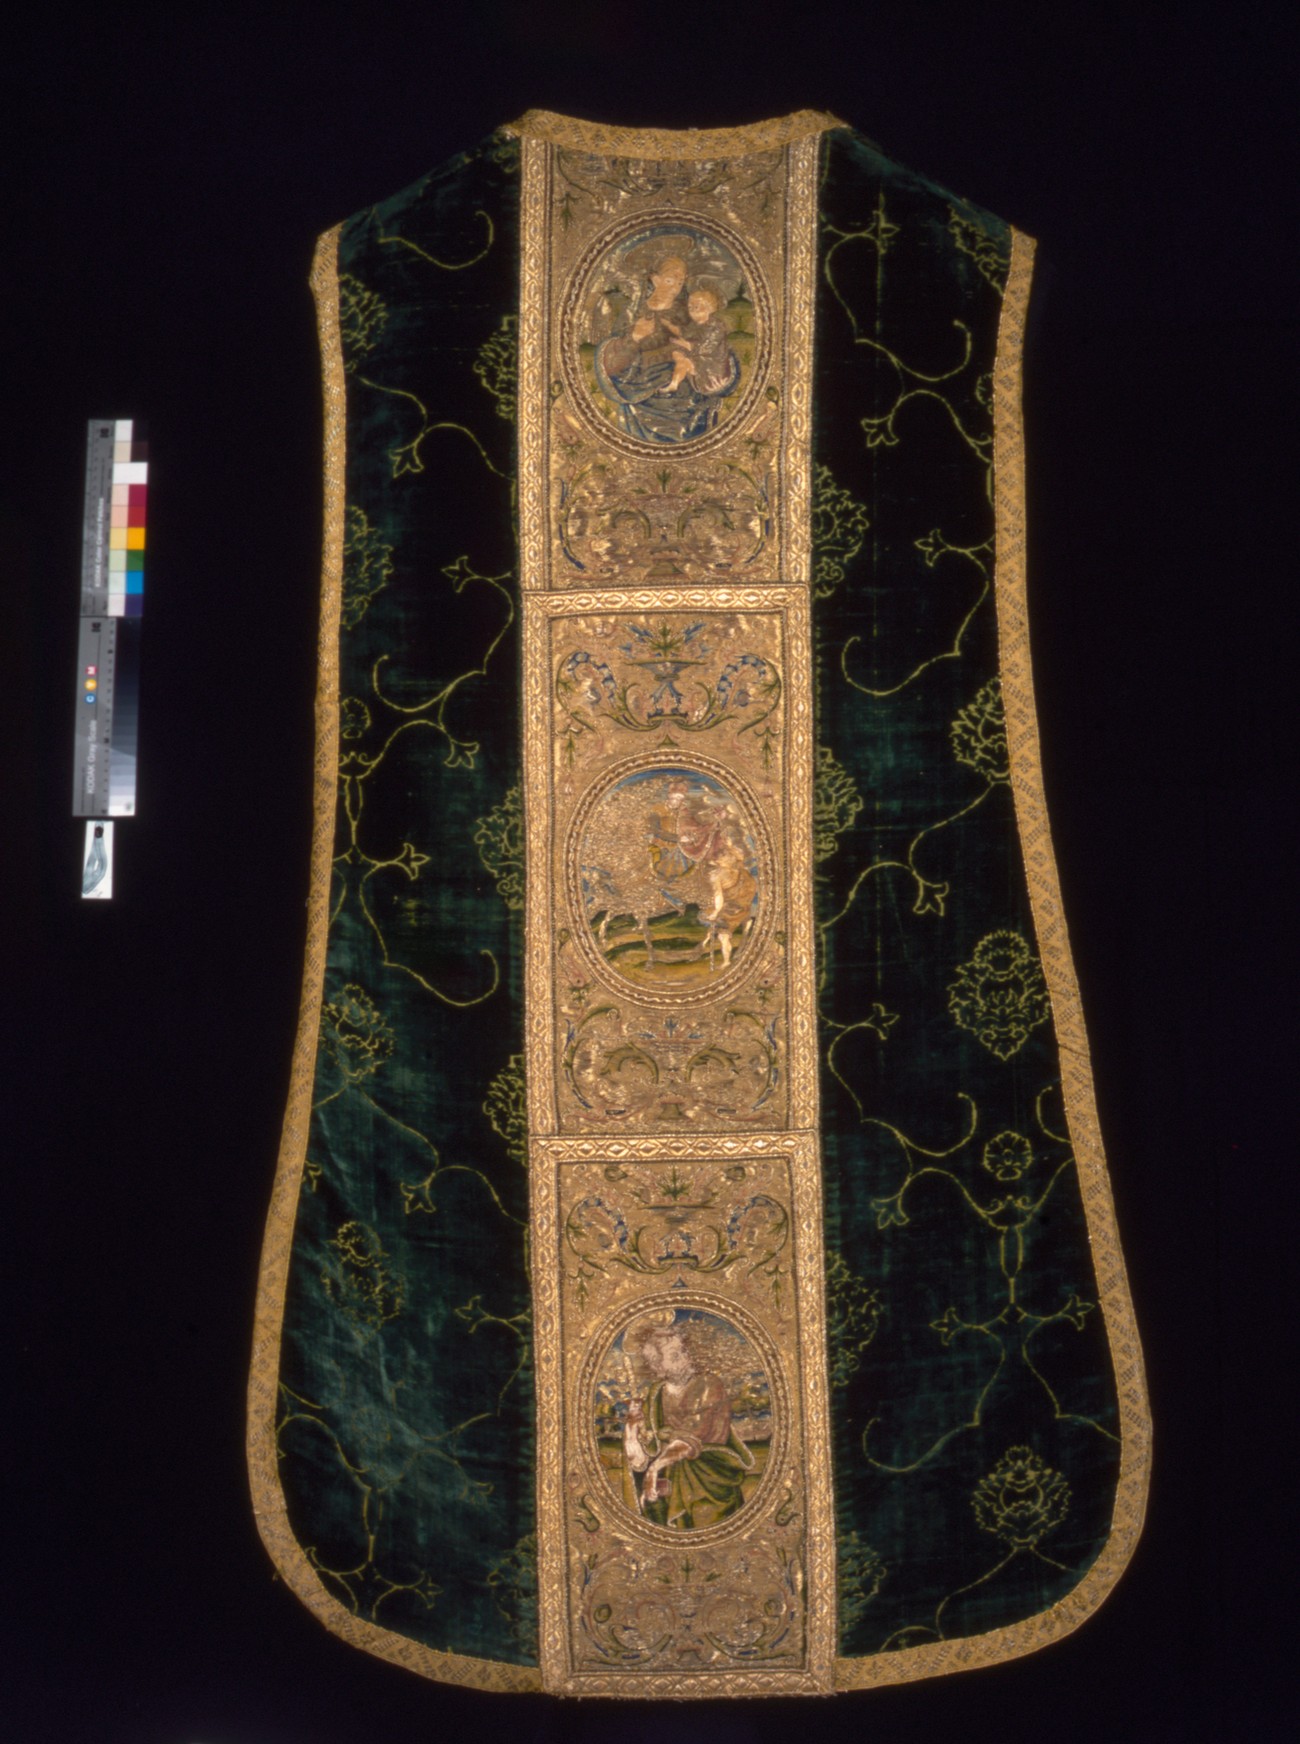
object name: chasuble with orphrey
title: Chasuble with Orphreys depicting a saint and bishop saint (front), the Virgin and Child, Saint Martin, and Saint Peter (back)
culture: italian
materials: velvet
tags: bishops,madonna and child,saint peter,saints